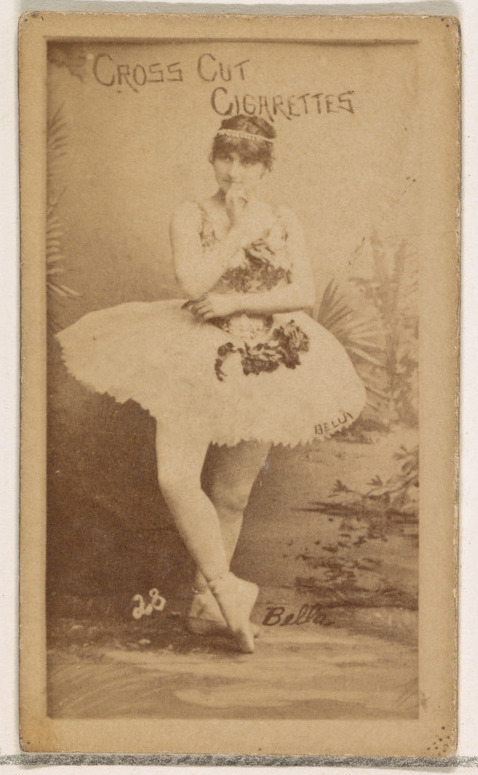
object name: print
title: Card Number 28, Bella, from the Actors and Actresses series (N145-1) issued by Duke Sons & Co. to promote Cross Cut Cigarettes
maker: w. duke, sons & co.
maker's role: publisher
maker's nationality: american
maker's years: 1870-1920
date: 1880-1889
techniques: albumen silver print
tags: portraits,women,actresses